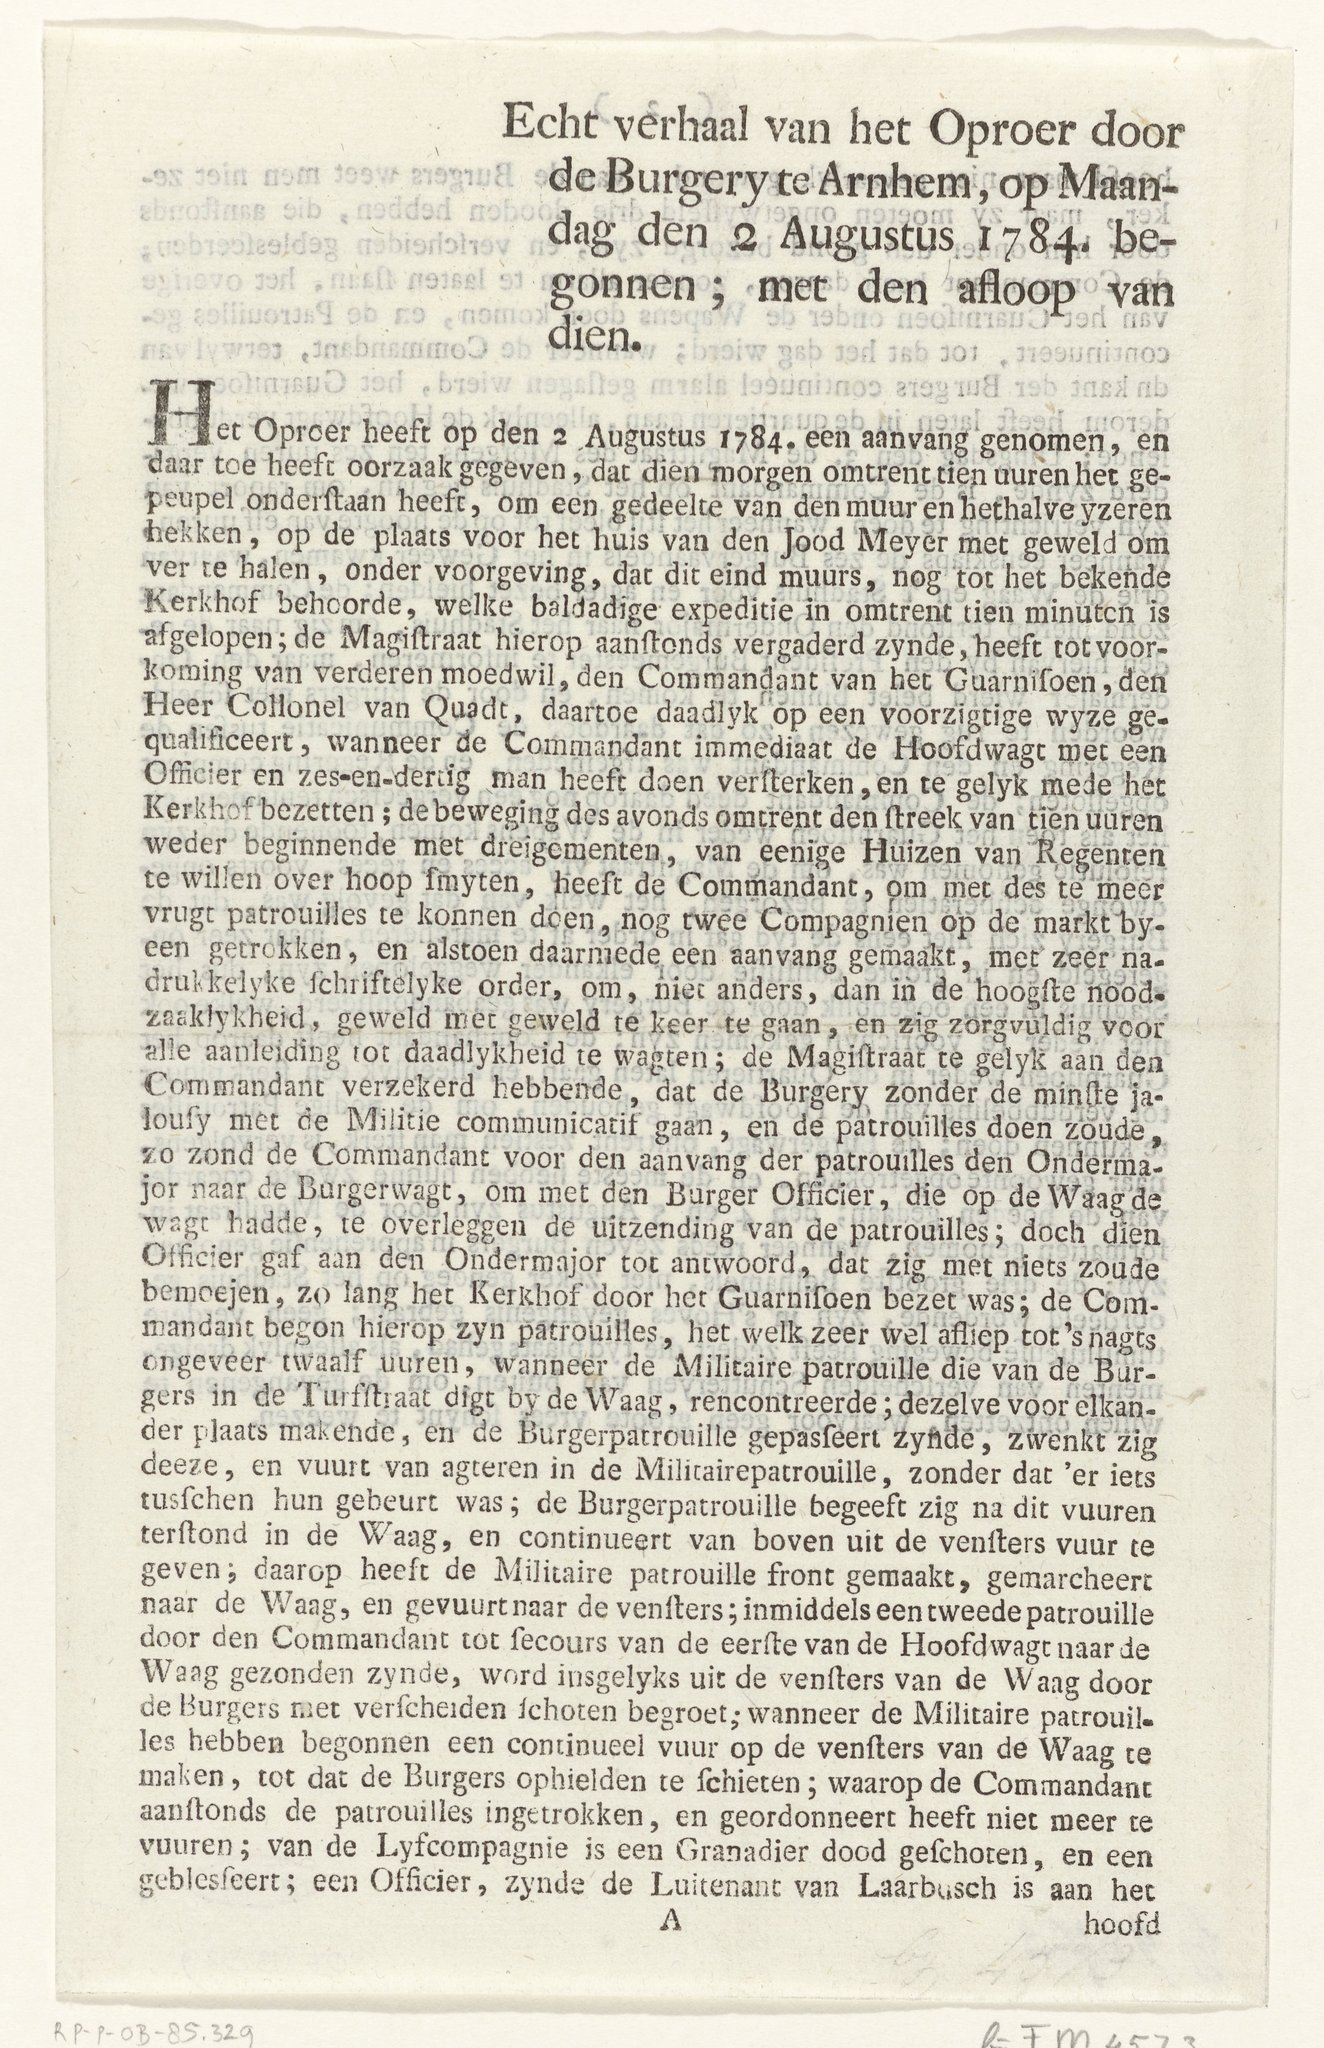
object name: text sheet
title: Echt verhaal van het Oproer door de Burgery te Arnhem, op Maandag den 2 Augustus 1784. begonnen; met den afloop van dien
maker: Anonymous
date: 1784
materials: paper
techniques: letterpress printing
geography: northern netherlands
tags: arnhem, patriots (1780-1795)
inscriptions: collector's mark: Lugt 2228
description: tekstblad met een beschrijving van de confrontatie tussen een patrouille door burgers en een militaire patrouille in de Turfstaat te Arnhem, 2 augustus 1784. Onlusten naar aanleiding van de kerkhofkwestie te Arnhem. Blad bedrukt op beide zijden.